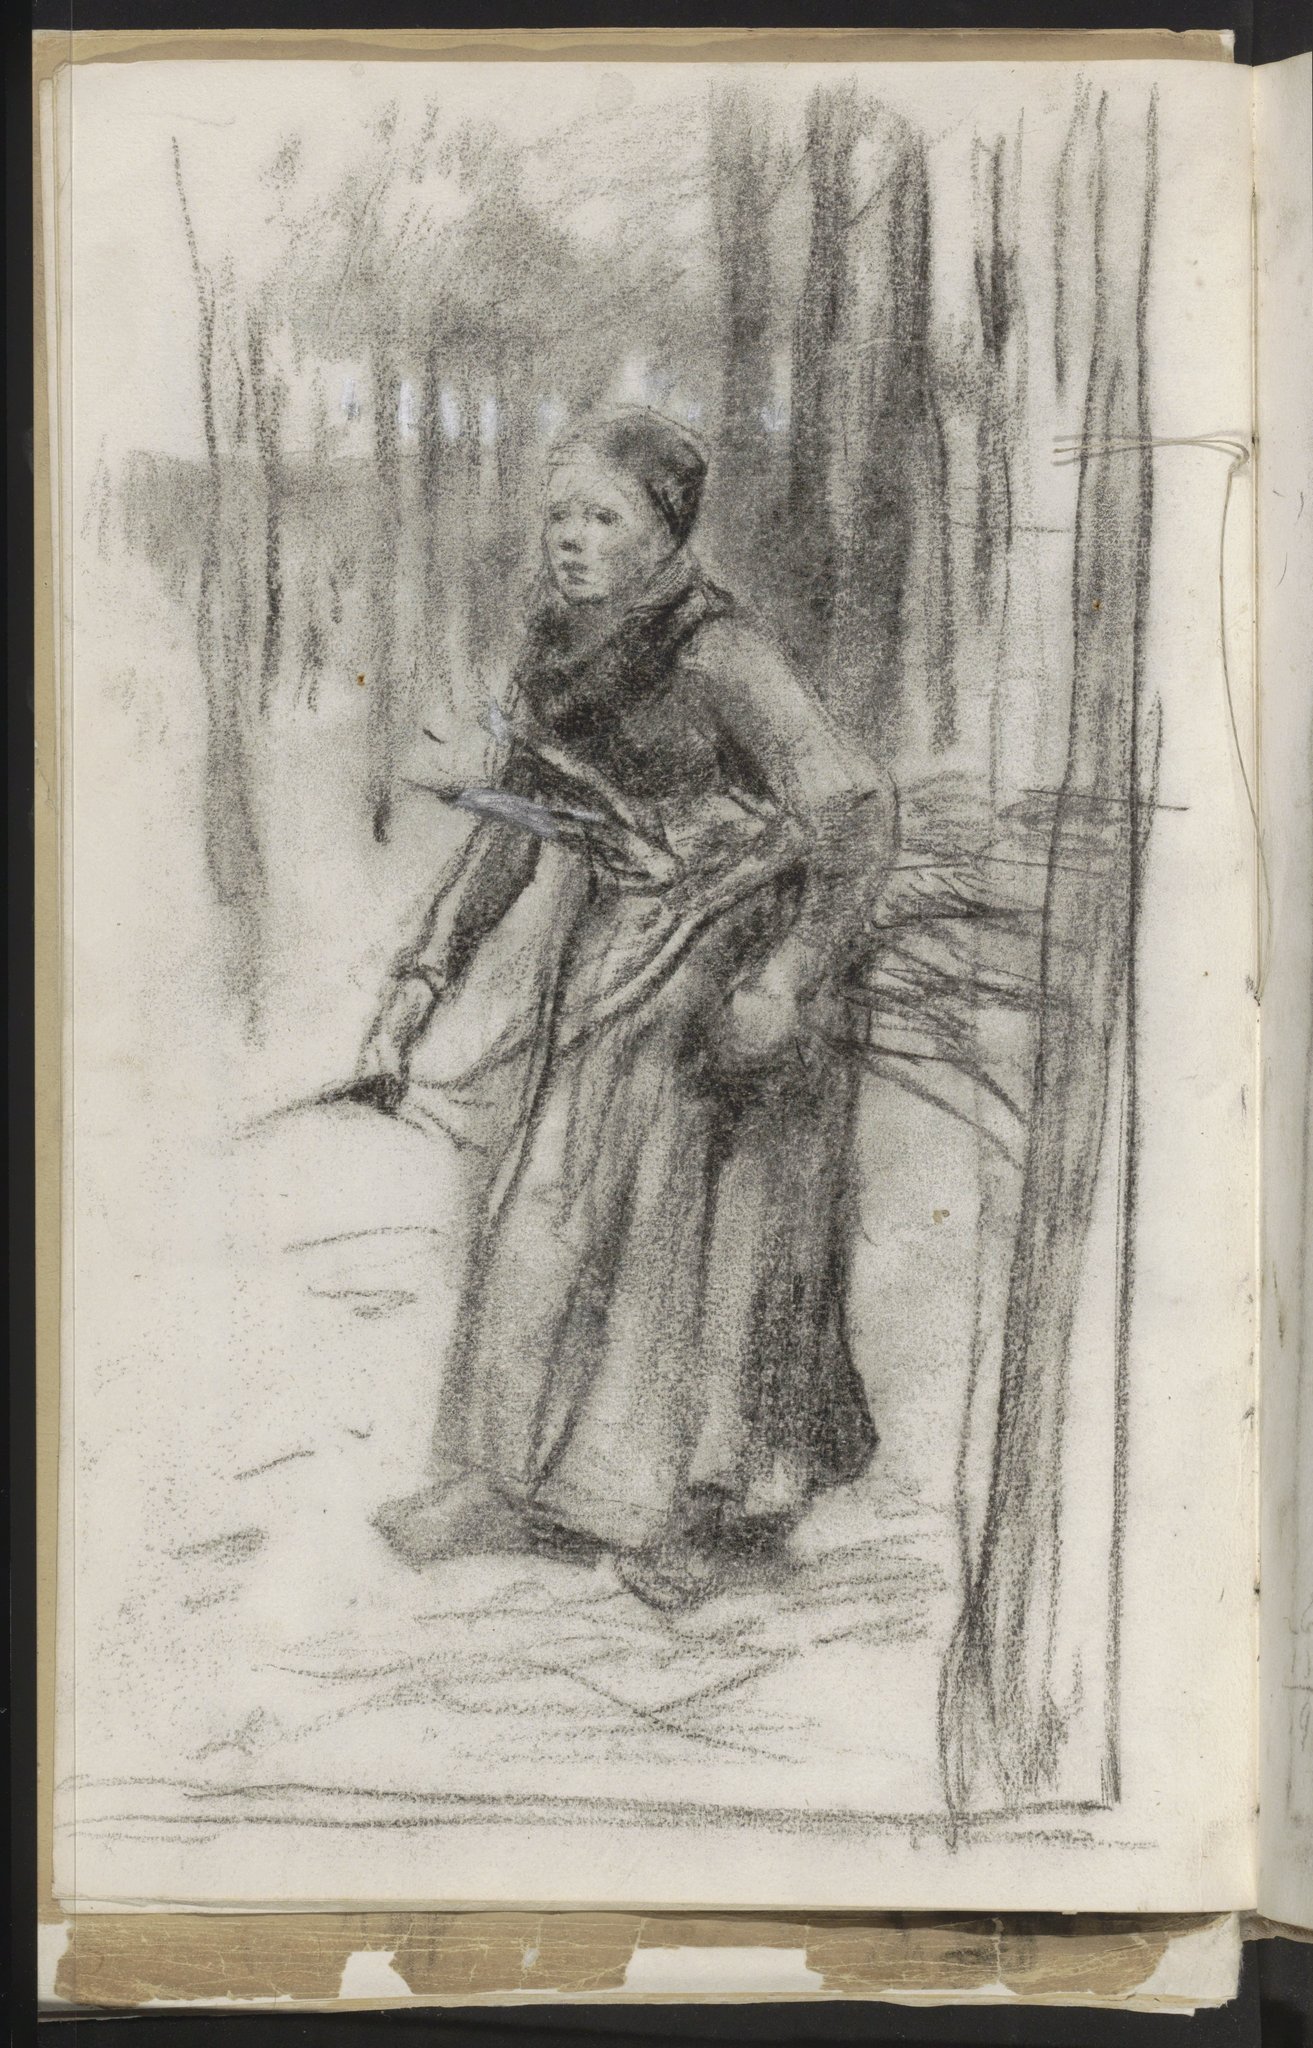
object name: sketchbook leaf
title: Jonge vrouw met sprokkelhout onder de arm in een bos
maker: albert neuhuys (1844-1914)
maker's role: draughtsman, painter, print maker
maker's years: 1844-1914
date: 1854-1914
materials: charcoal, paint, paper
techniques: brush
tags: adult woman, forest, wood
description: Blad 17 verso uit een schetsboek met 53 bladen.